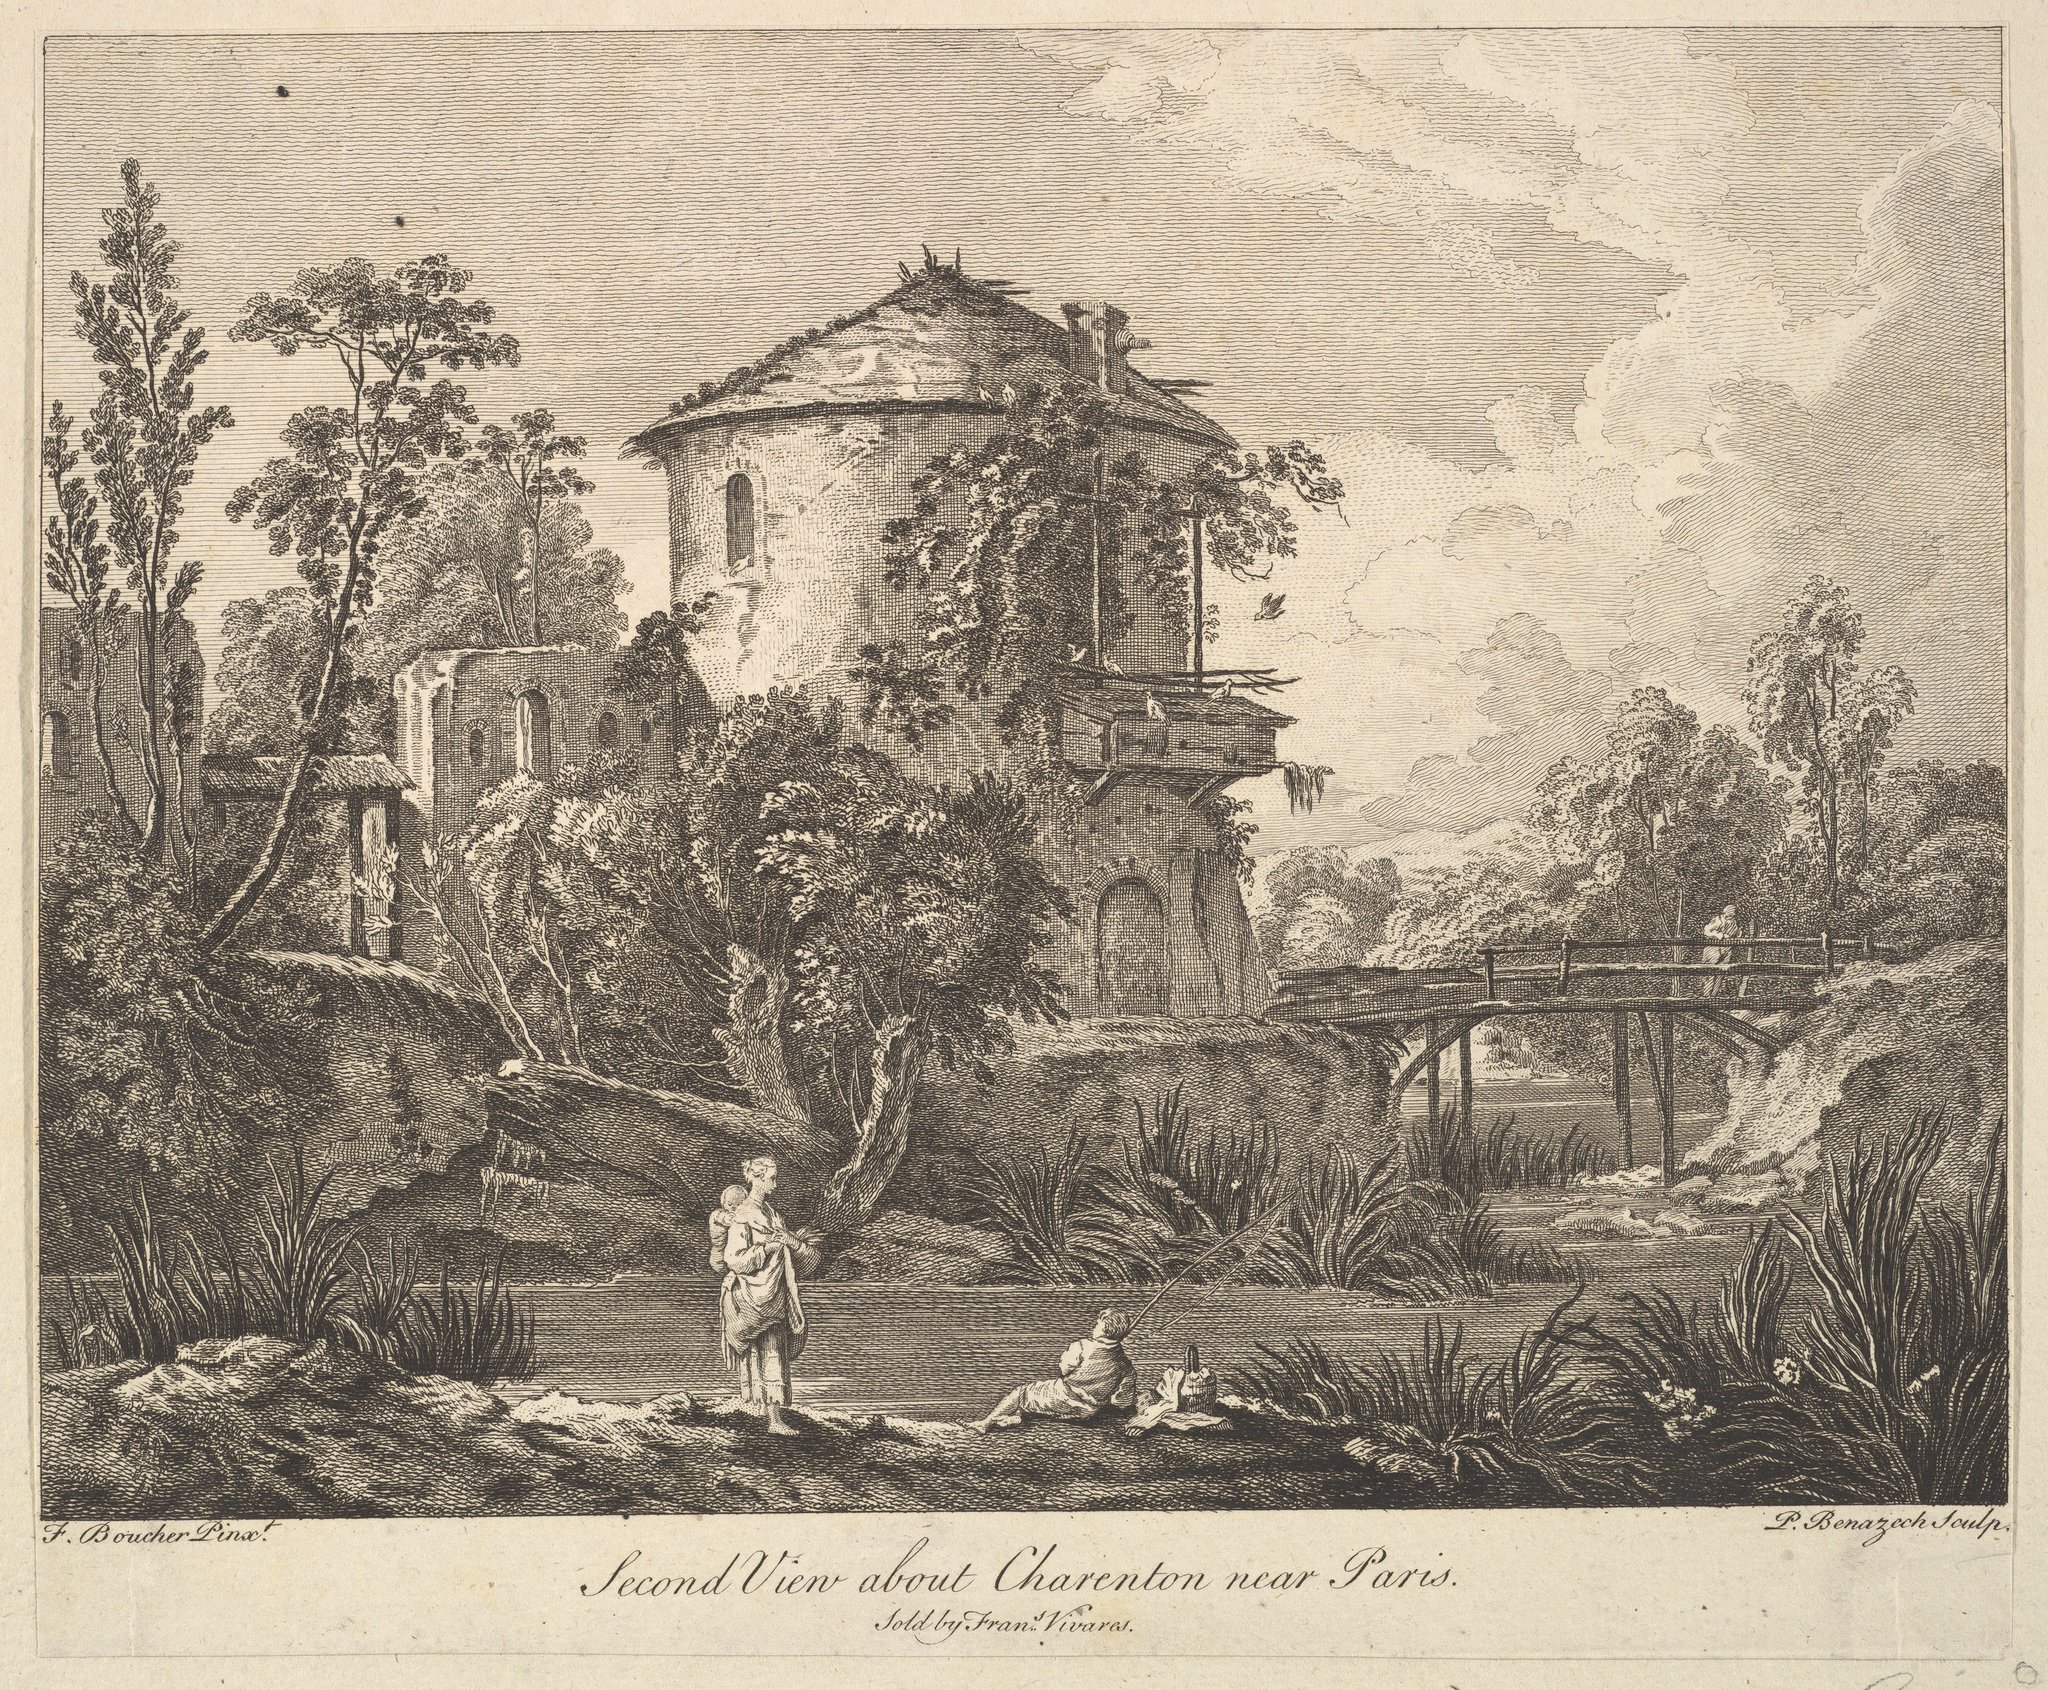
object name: print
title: Second View of Charenton near Paris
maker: peter paul benazech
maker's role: artist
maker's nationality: british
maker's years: 1730-1783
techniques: engraving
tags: children,boys,women,fishing,landscapes